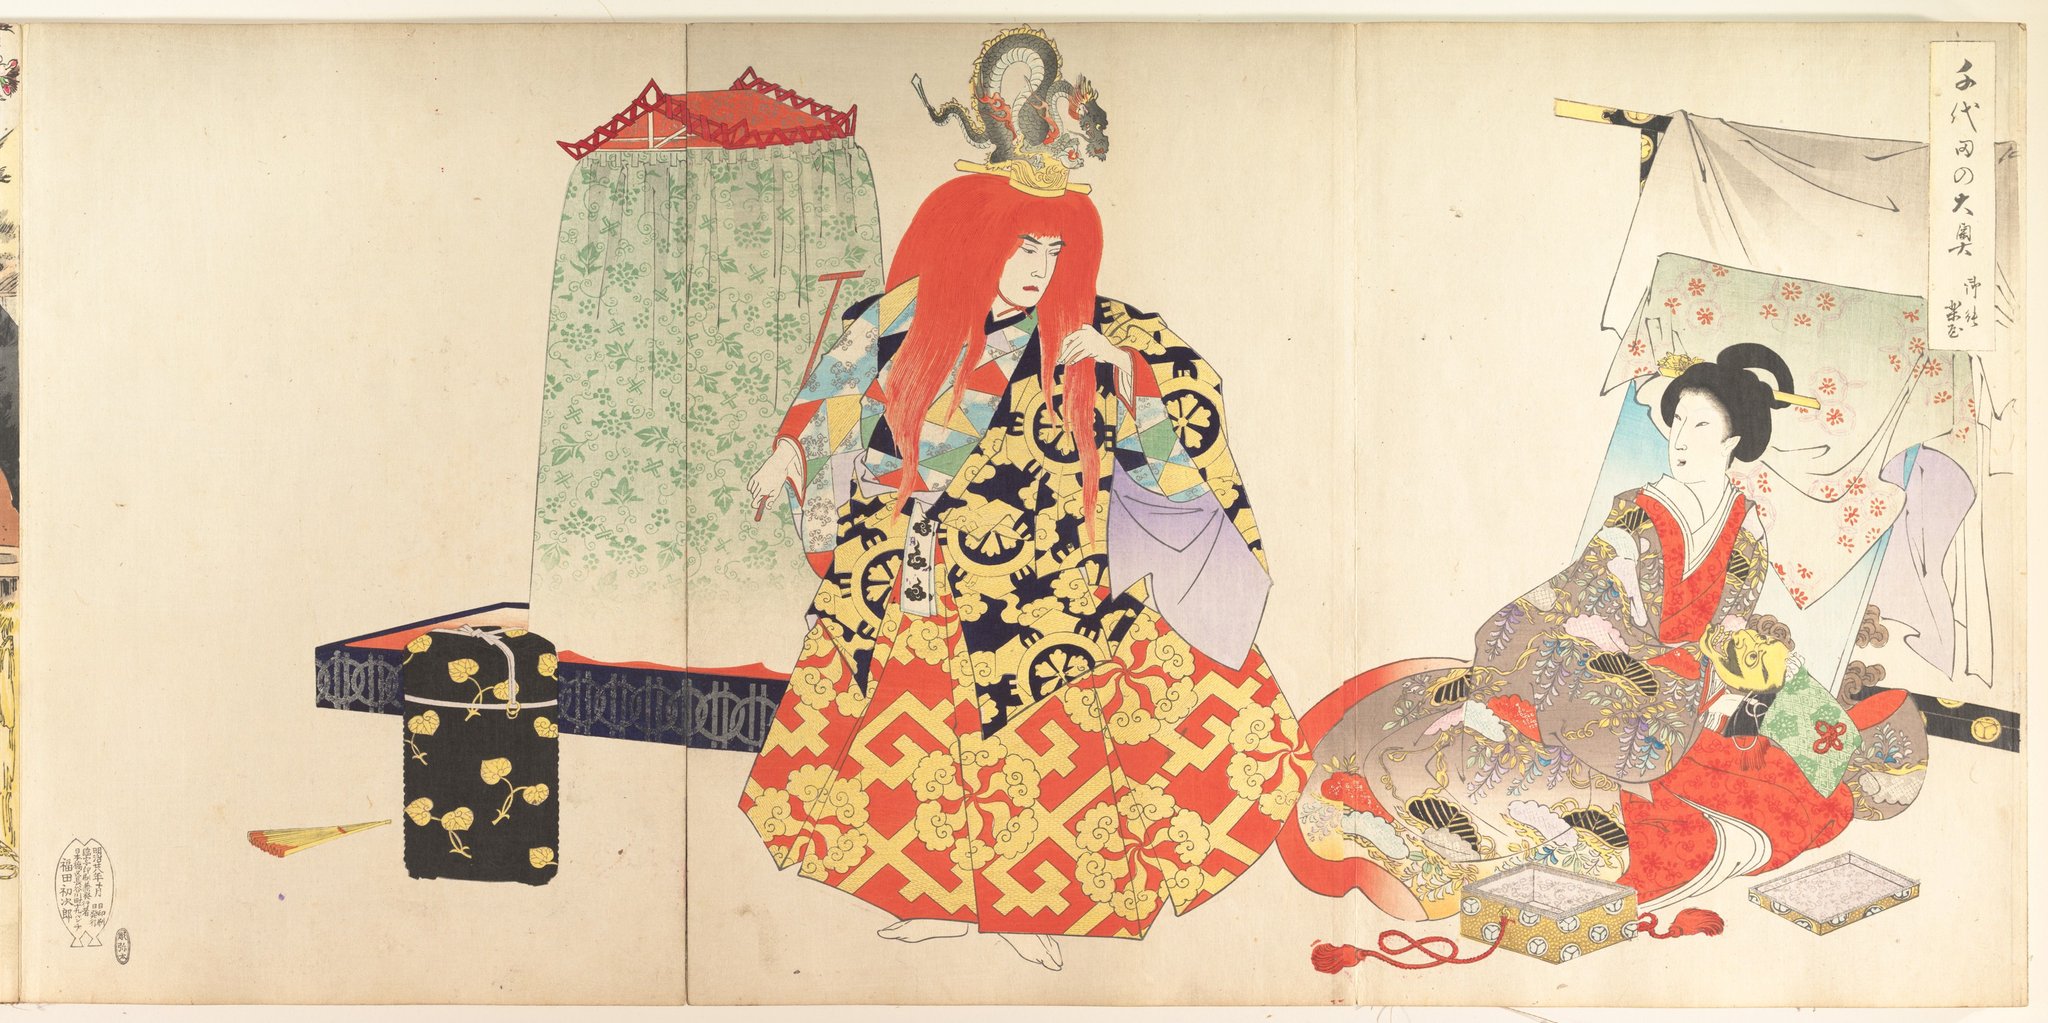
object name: print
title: Chiyoda Castle (Album of Women)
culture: japanese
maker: yōshū (hashimoto) chikanobu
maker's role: artist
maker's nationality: japanese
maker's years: 1838-1912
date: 1895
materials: ink, paper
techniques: woodblock print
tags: women,dragons